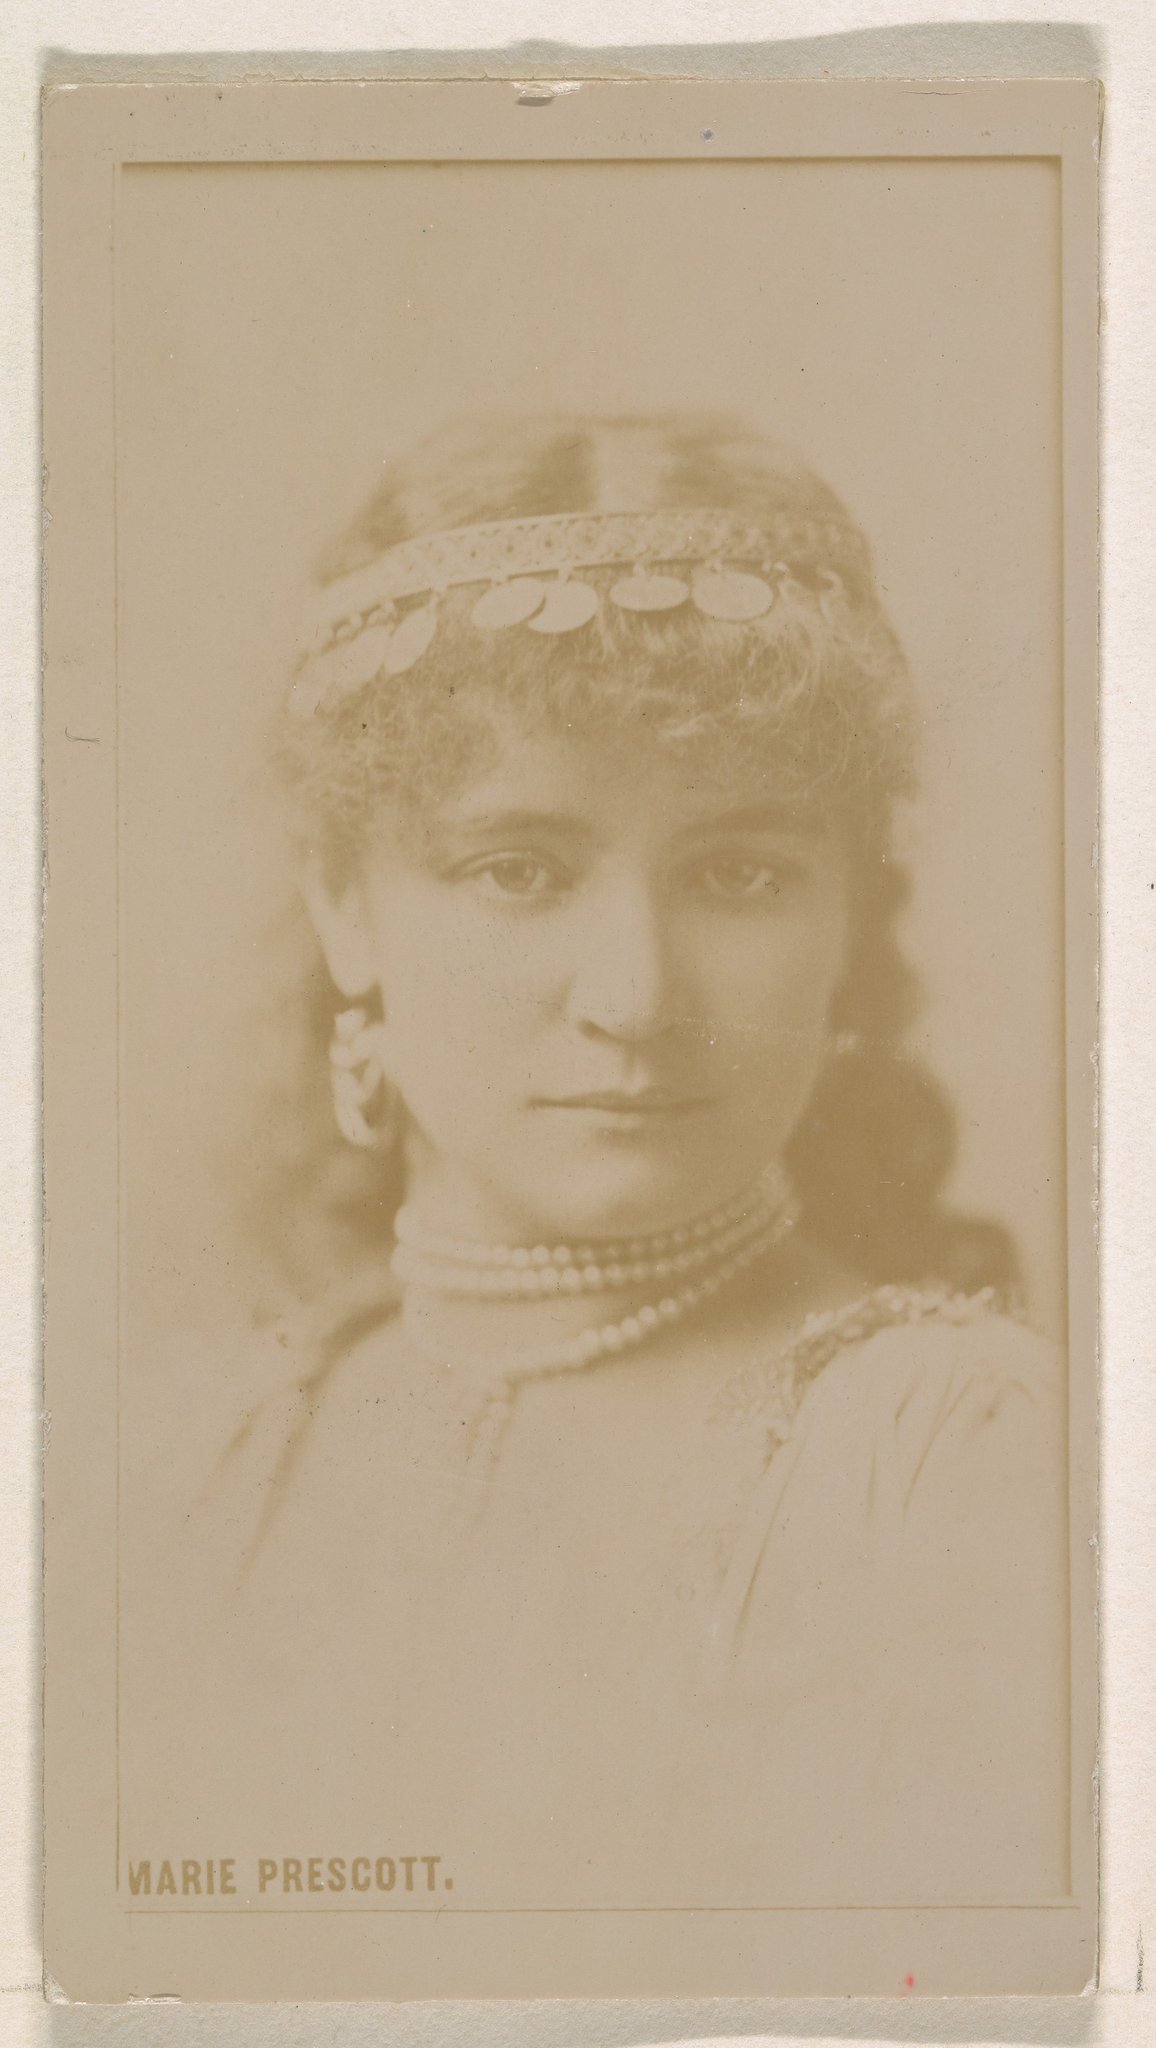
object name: photograph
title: Marie Prescott, from the Actresses series (N245) issued by Kinney Brothers to promote Sweet Caporal Cigarettes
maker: kinney brothers tobacco company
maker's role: publisher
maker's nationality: american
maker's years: 1869-2011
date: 1890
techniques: albumen silver print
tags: portraits,women,actresses